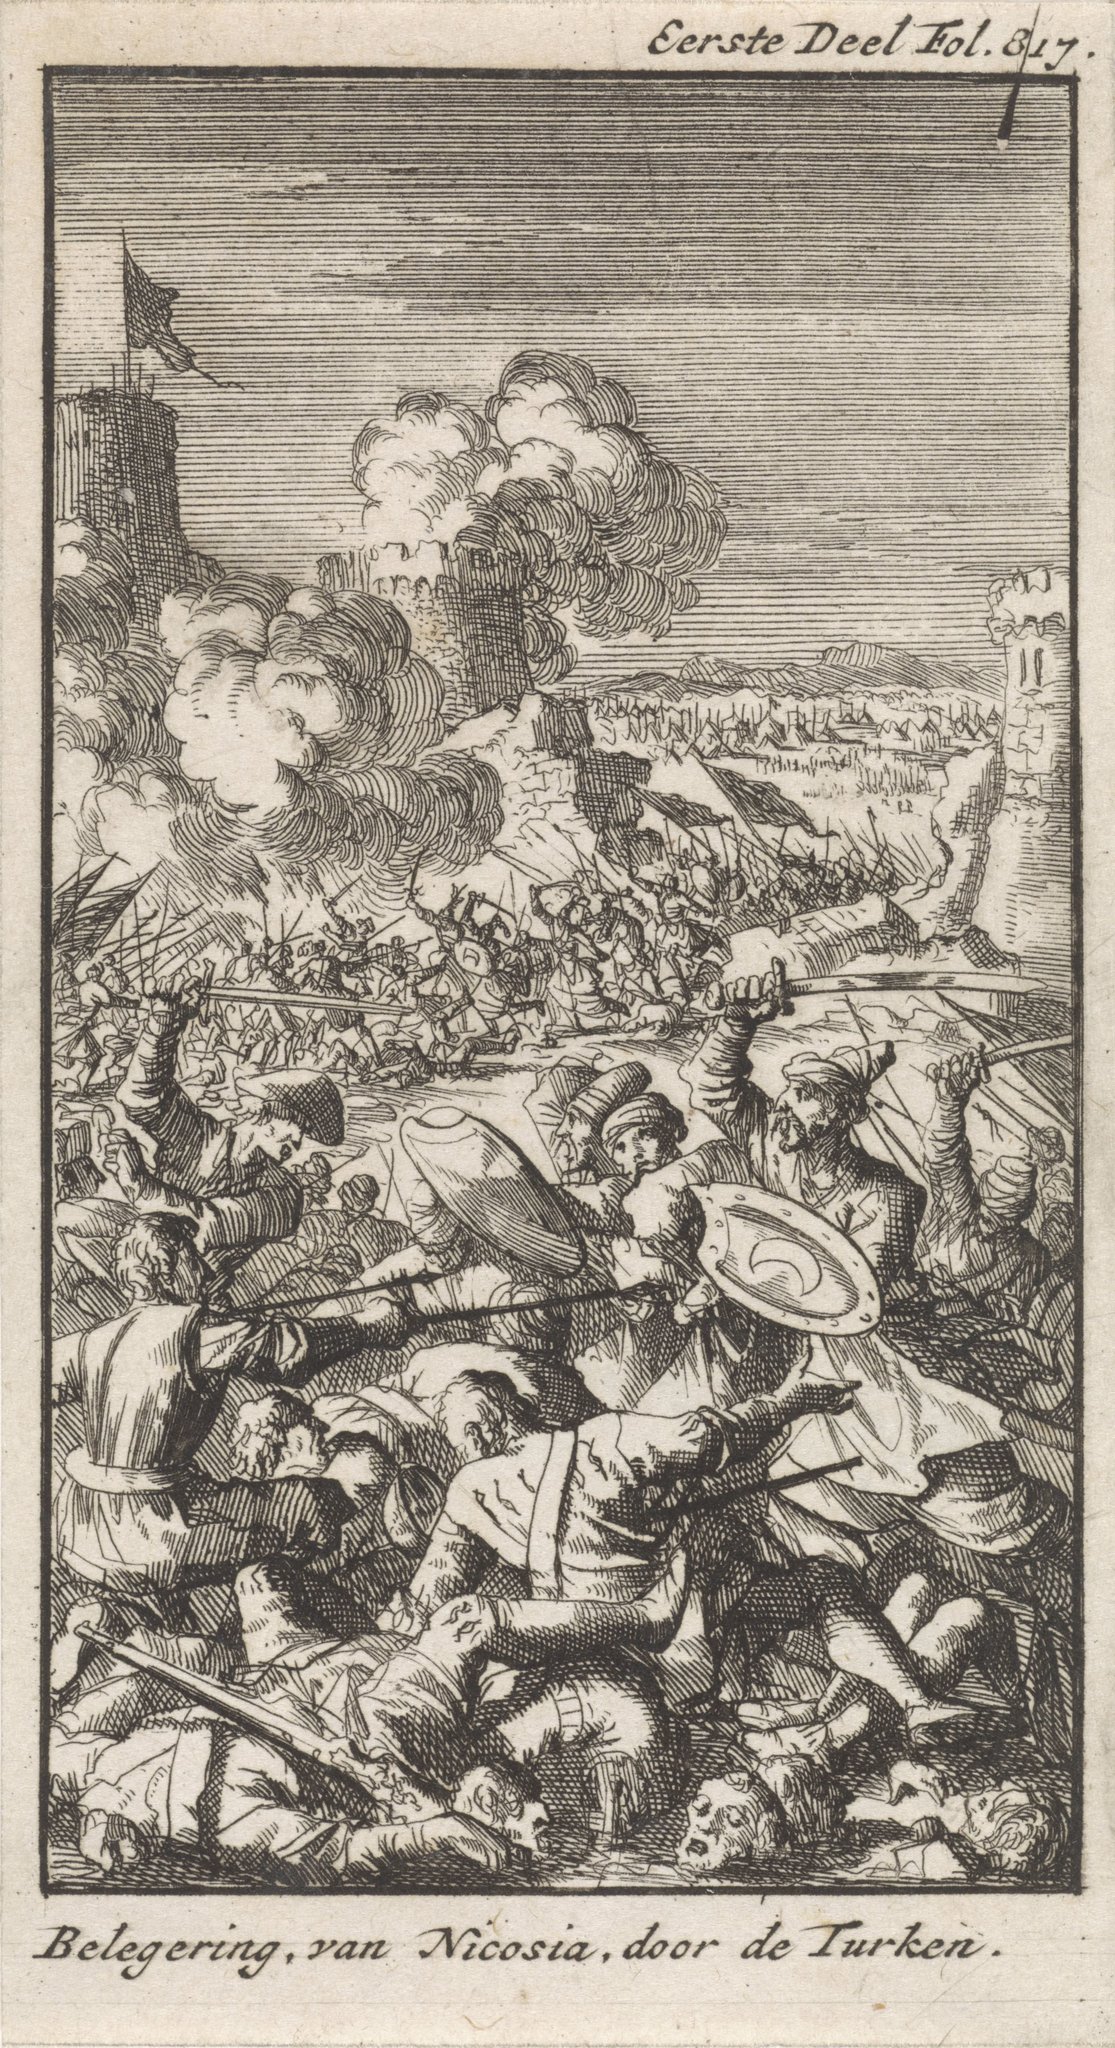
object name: history print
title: Belegering, van Nicosia, door de Turken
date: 1699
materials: paper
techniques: etching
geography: amsterdam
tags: asiatic races and peoples: turks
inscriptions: collector's mark: Lugt 2228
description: Het Ottomaanse leger heeft een bres geslagen in een van de muren van de stad Nicosia in Cyprus. De Ottomaanse soldaten stromen de stad binnen en vallen de resterende verdedigers van de stad aan.